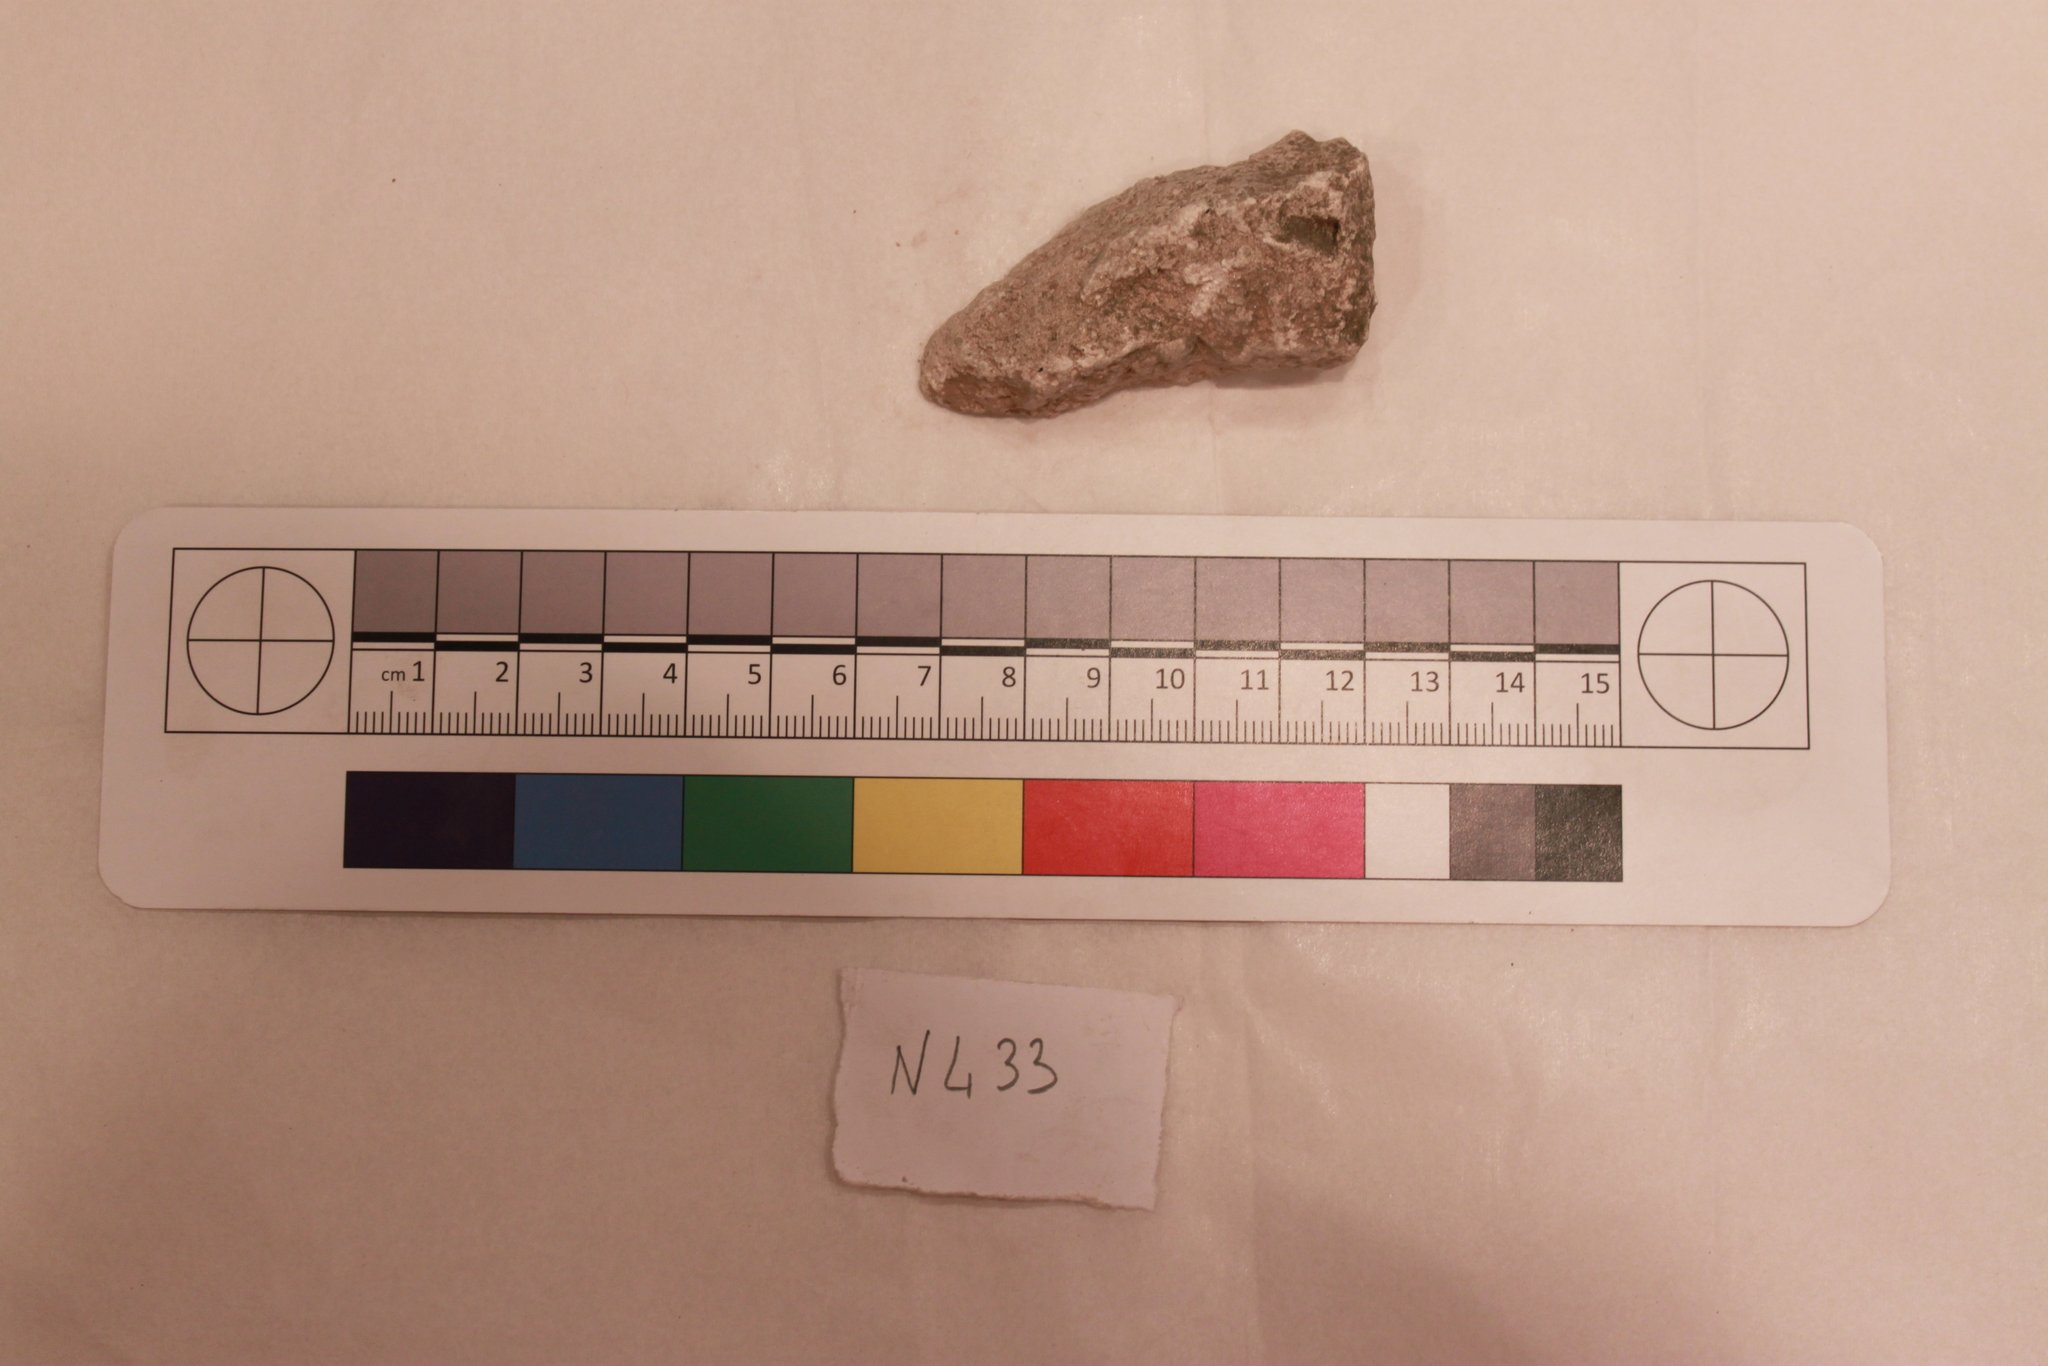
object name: fragment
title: Stucco Fragment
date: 701-1200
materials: plaster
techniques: carving, painting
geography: iran